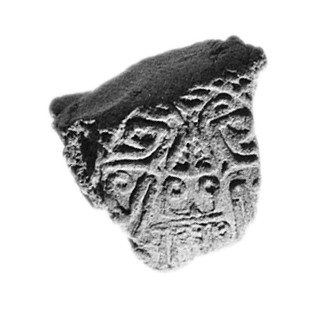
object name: sealing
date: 1981-1640 BCE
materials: mud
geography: egypt